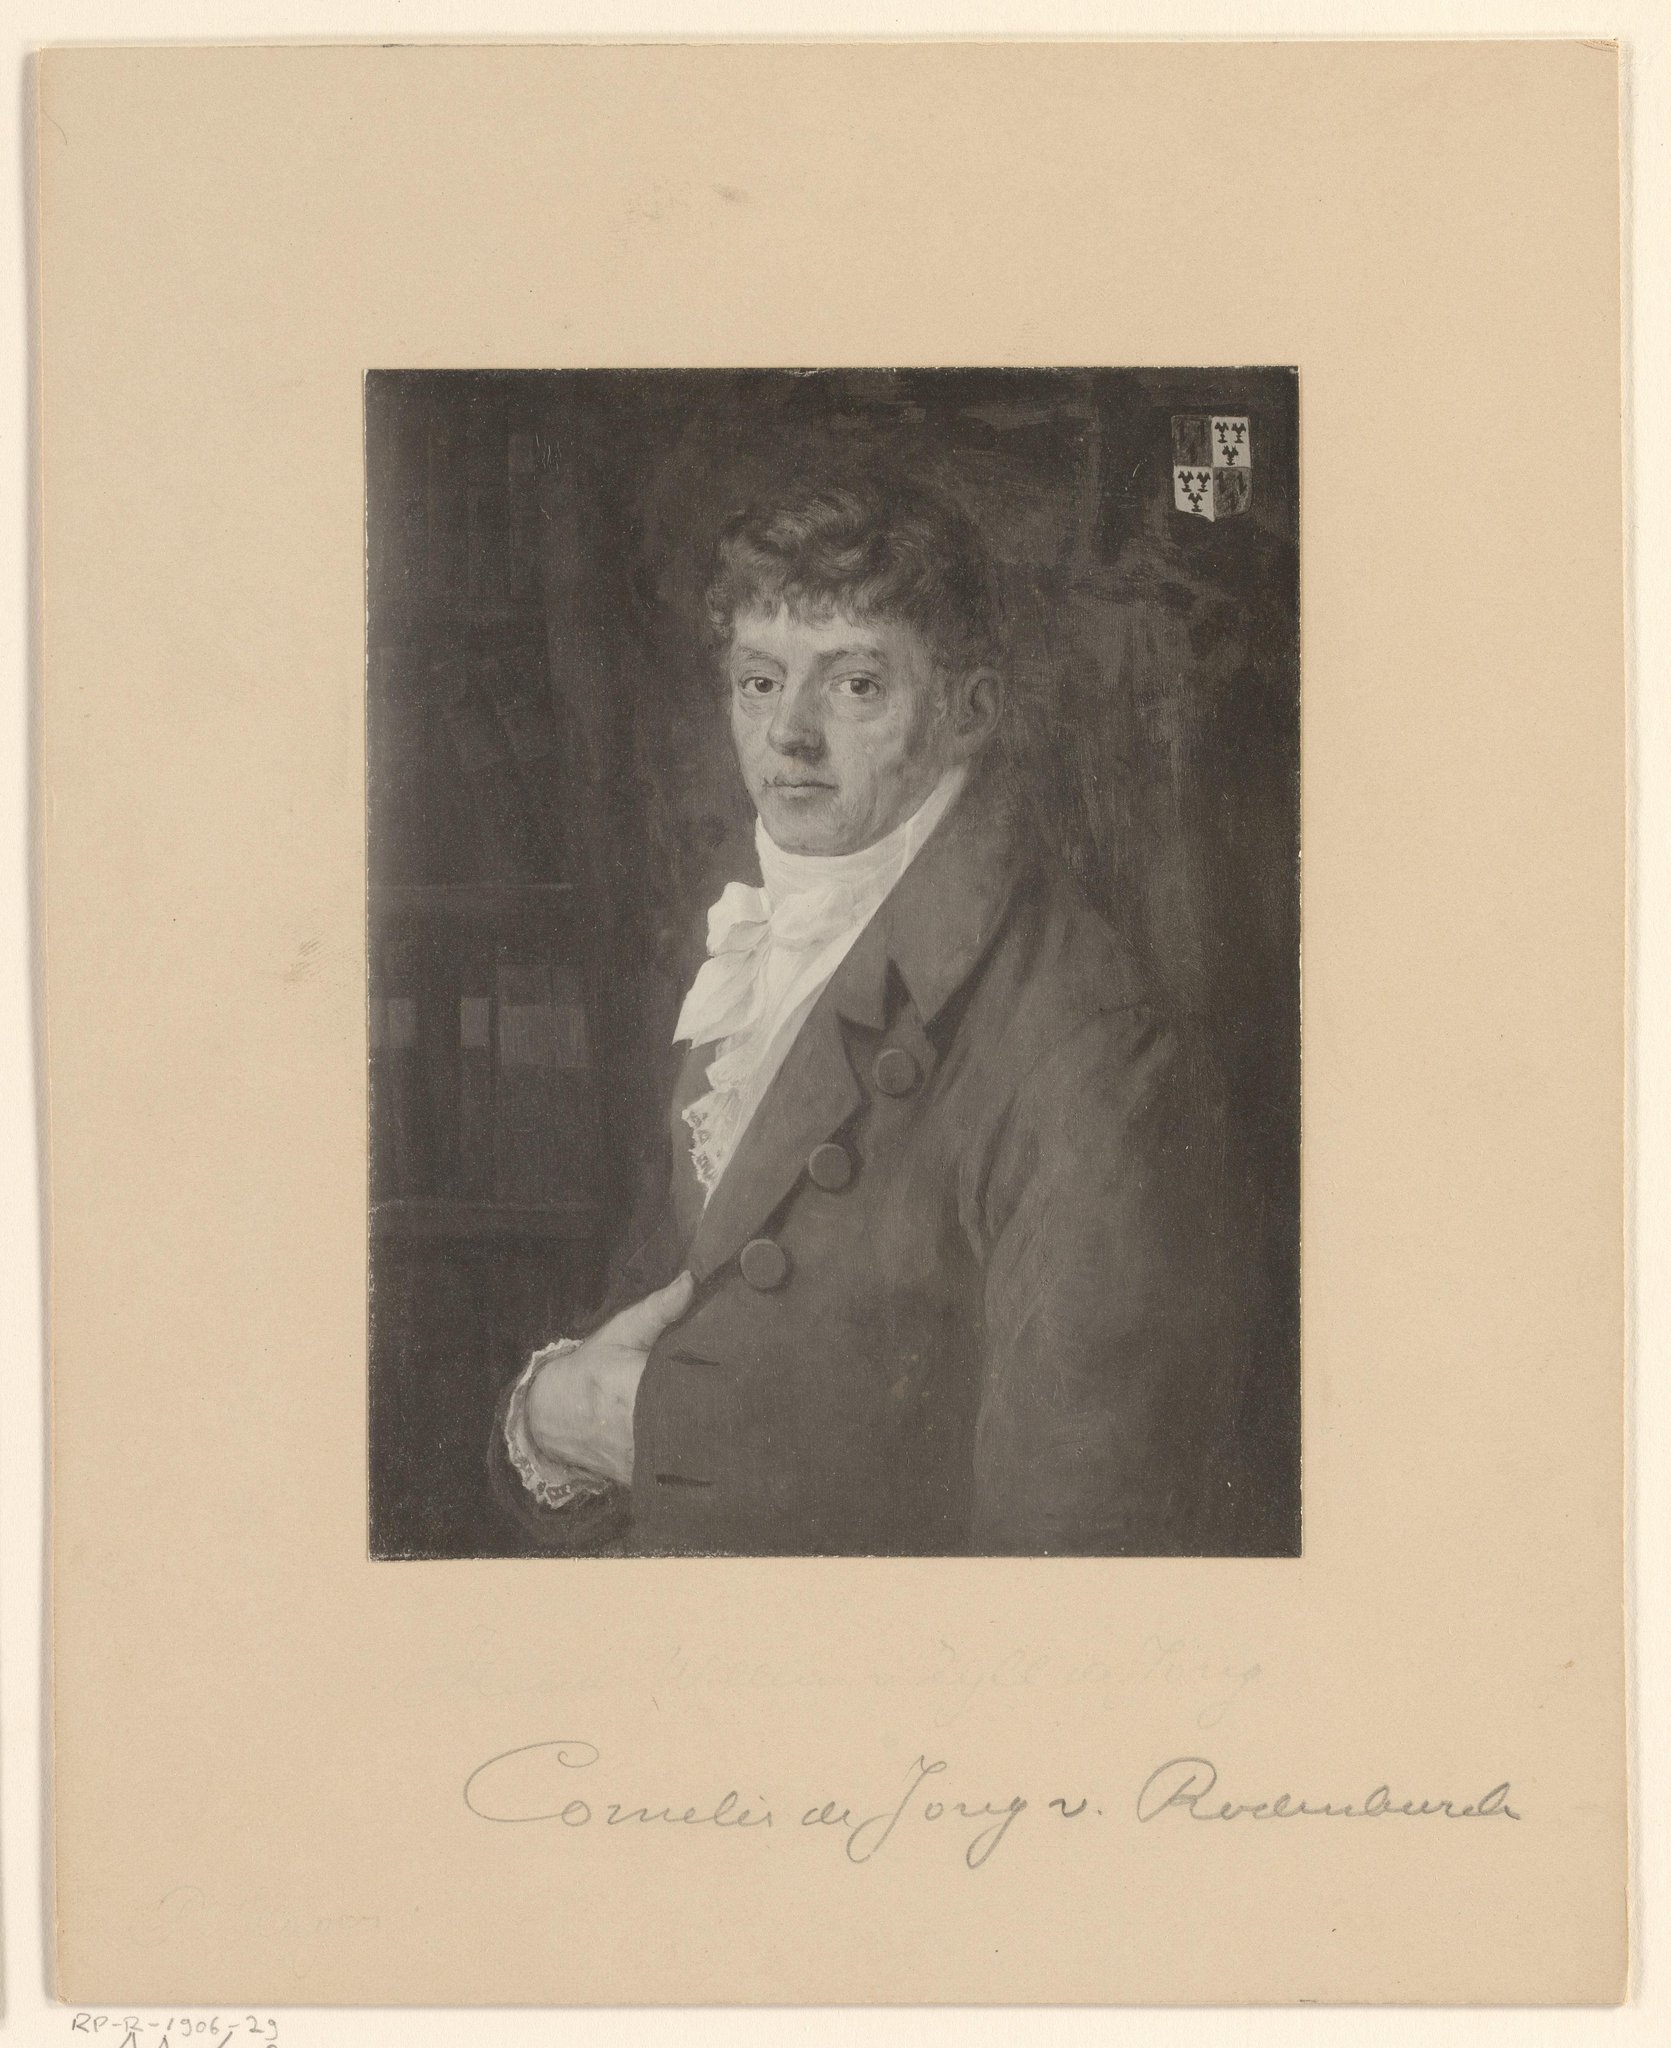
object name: photograph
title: Fotoreproductie van een geschilderd portret van Cornelis de Jong van Rodenburgh, door Piet Slager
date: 1890-1906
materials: paper, cardboard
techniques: gelatin silver print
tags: the hague, historical persons